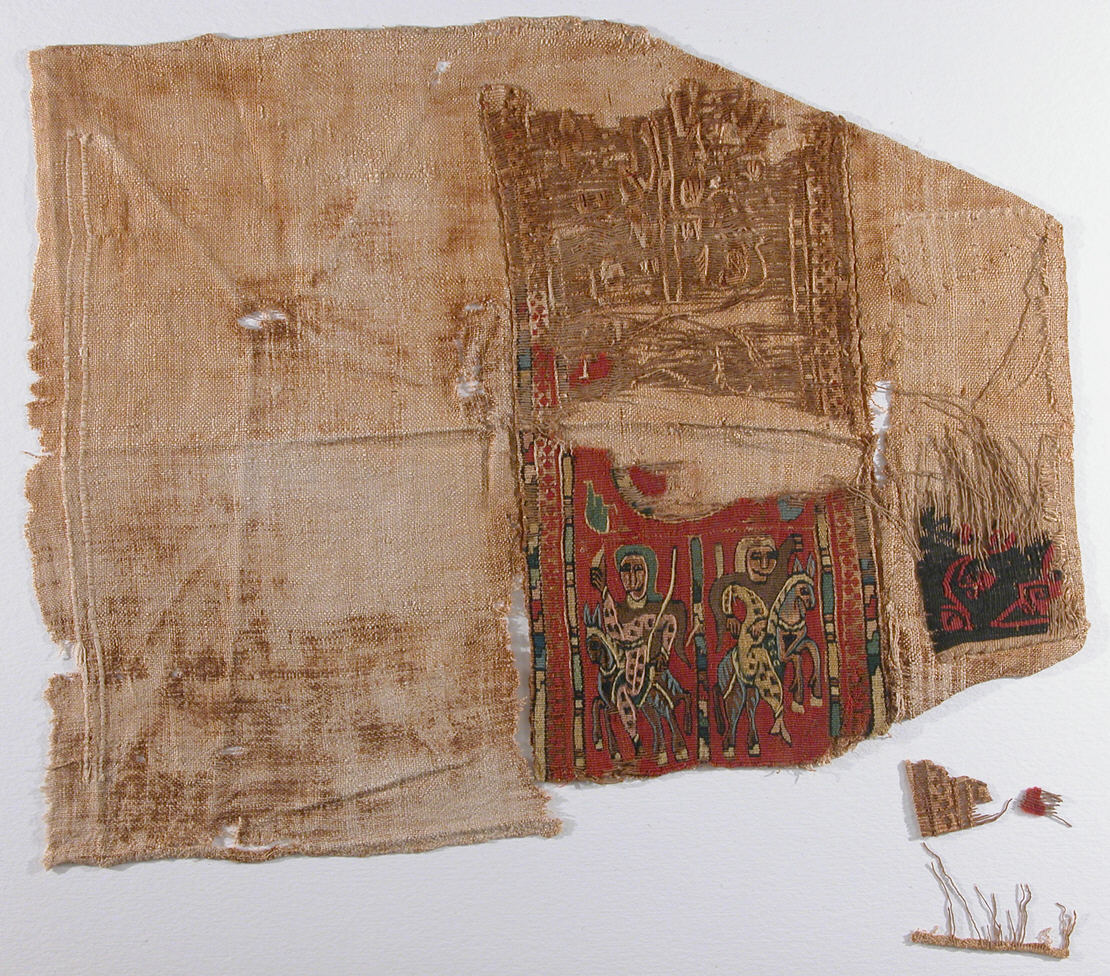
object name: textile fragment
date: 601-800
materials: linen, wool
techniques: weave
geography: egypt